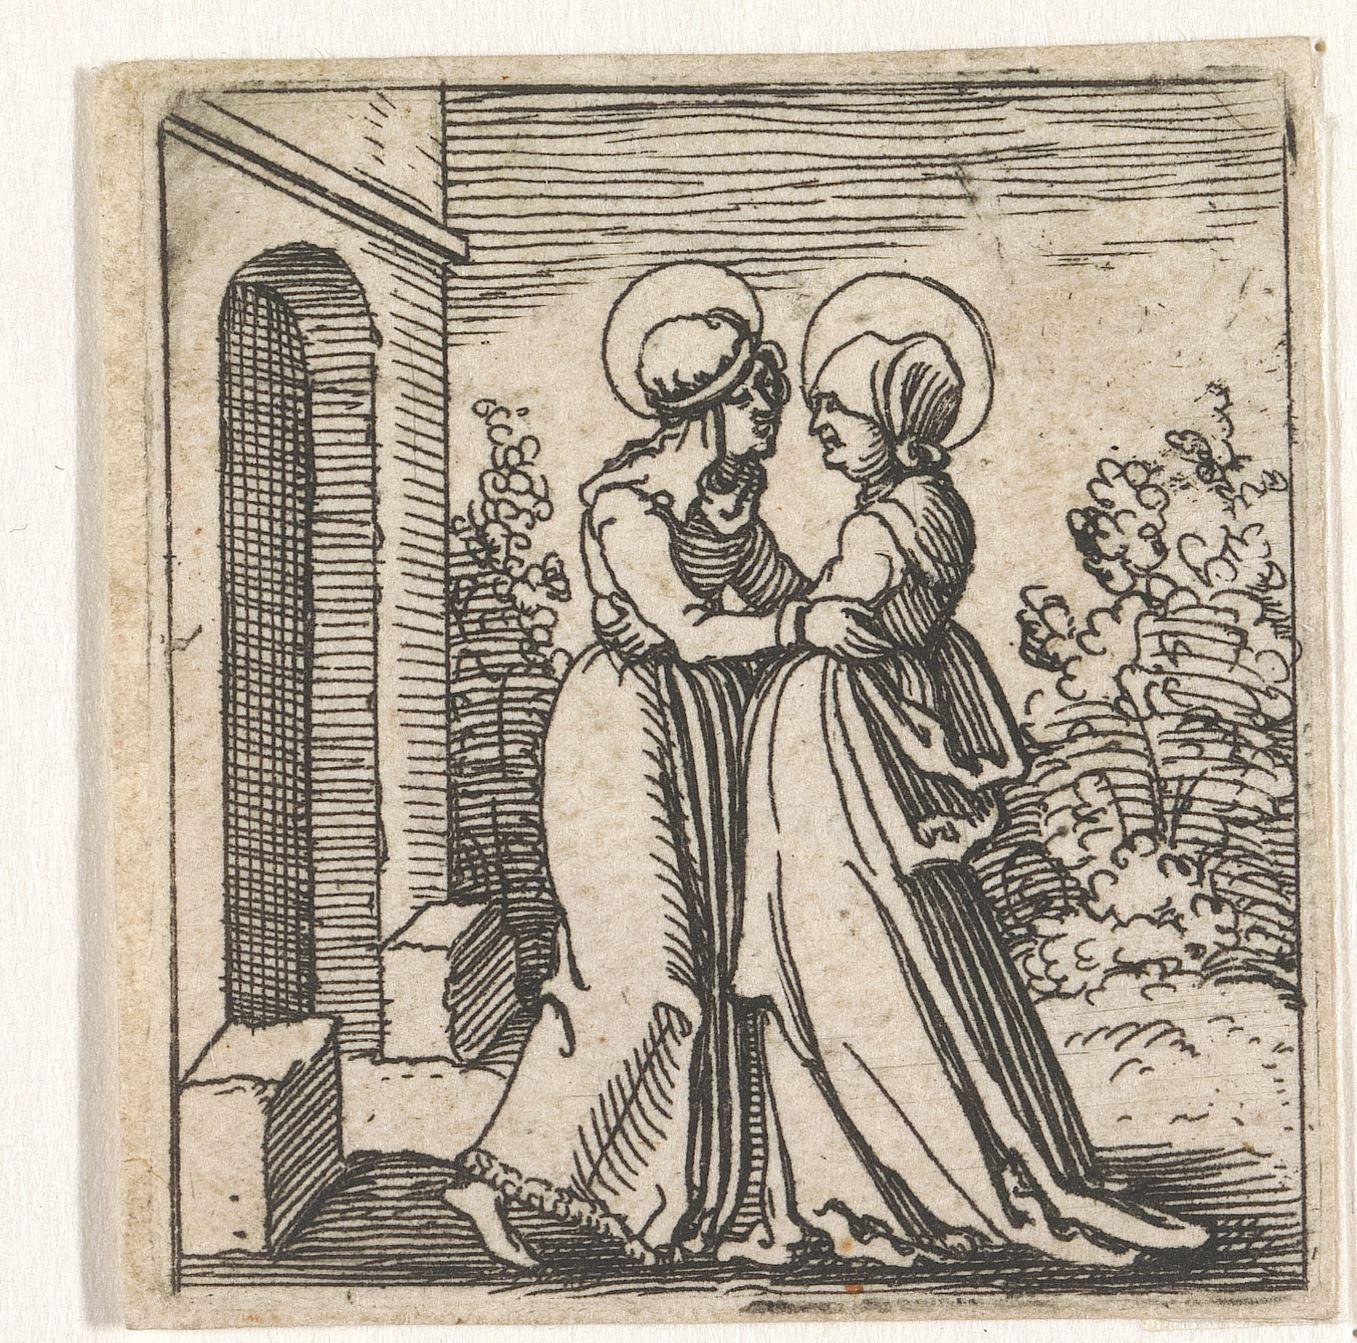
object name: print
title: Visitatie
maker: michiel le blon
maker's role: print maker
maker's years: 1587-1656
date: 1597-1656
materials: paper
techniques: etching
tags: mary and elisabeth, both pregnant, embracing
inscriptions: collector's mark: Lugt 240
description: Het bezoek van Maria aan haar nicht Elisabet, vlak na de annunciatie. Maria en Elisabet omhelzen elkaar. De prent maakt deel uit van een twaalfdelige serie prenten met scènes uit het leven van Christus en de Maagd Maria.